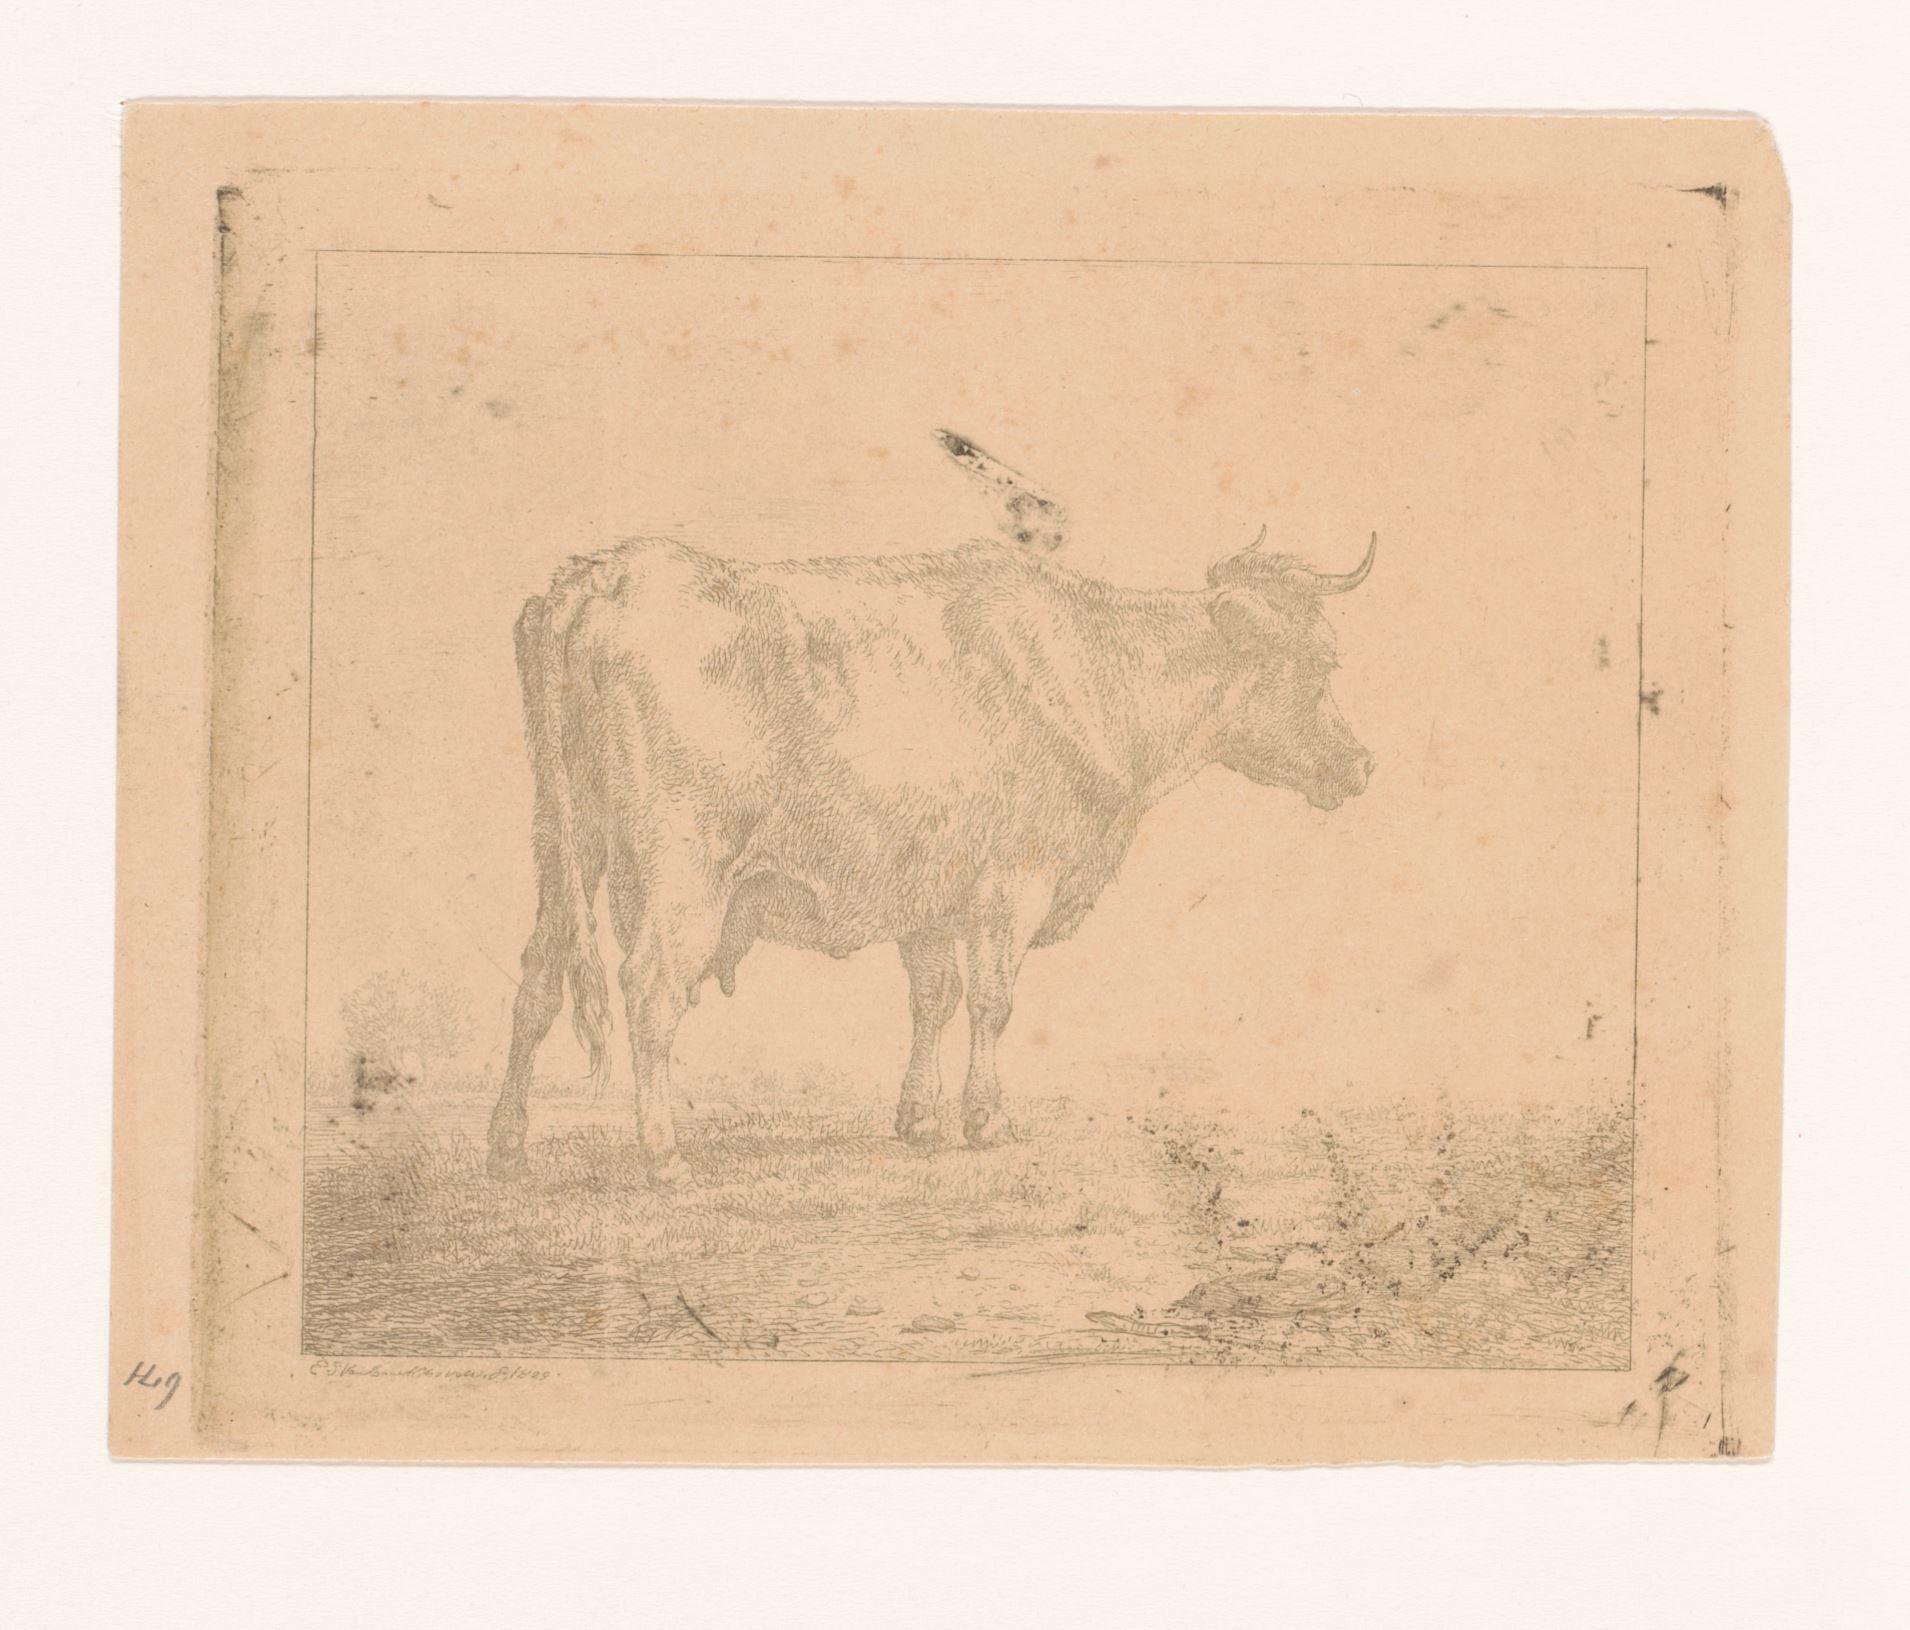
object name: print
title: Koe in een wei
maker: eugène verboeckhoven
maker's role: draughtsman, painter, print maker, printer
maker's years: 1798-1881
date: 1829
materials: paper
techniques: etching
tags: cow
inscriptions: date